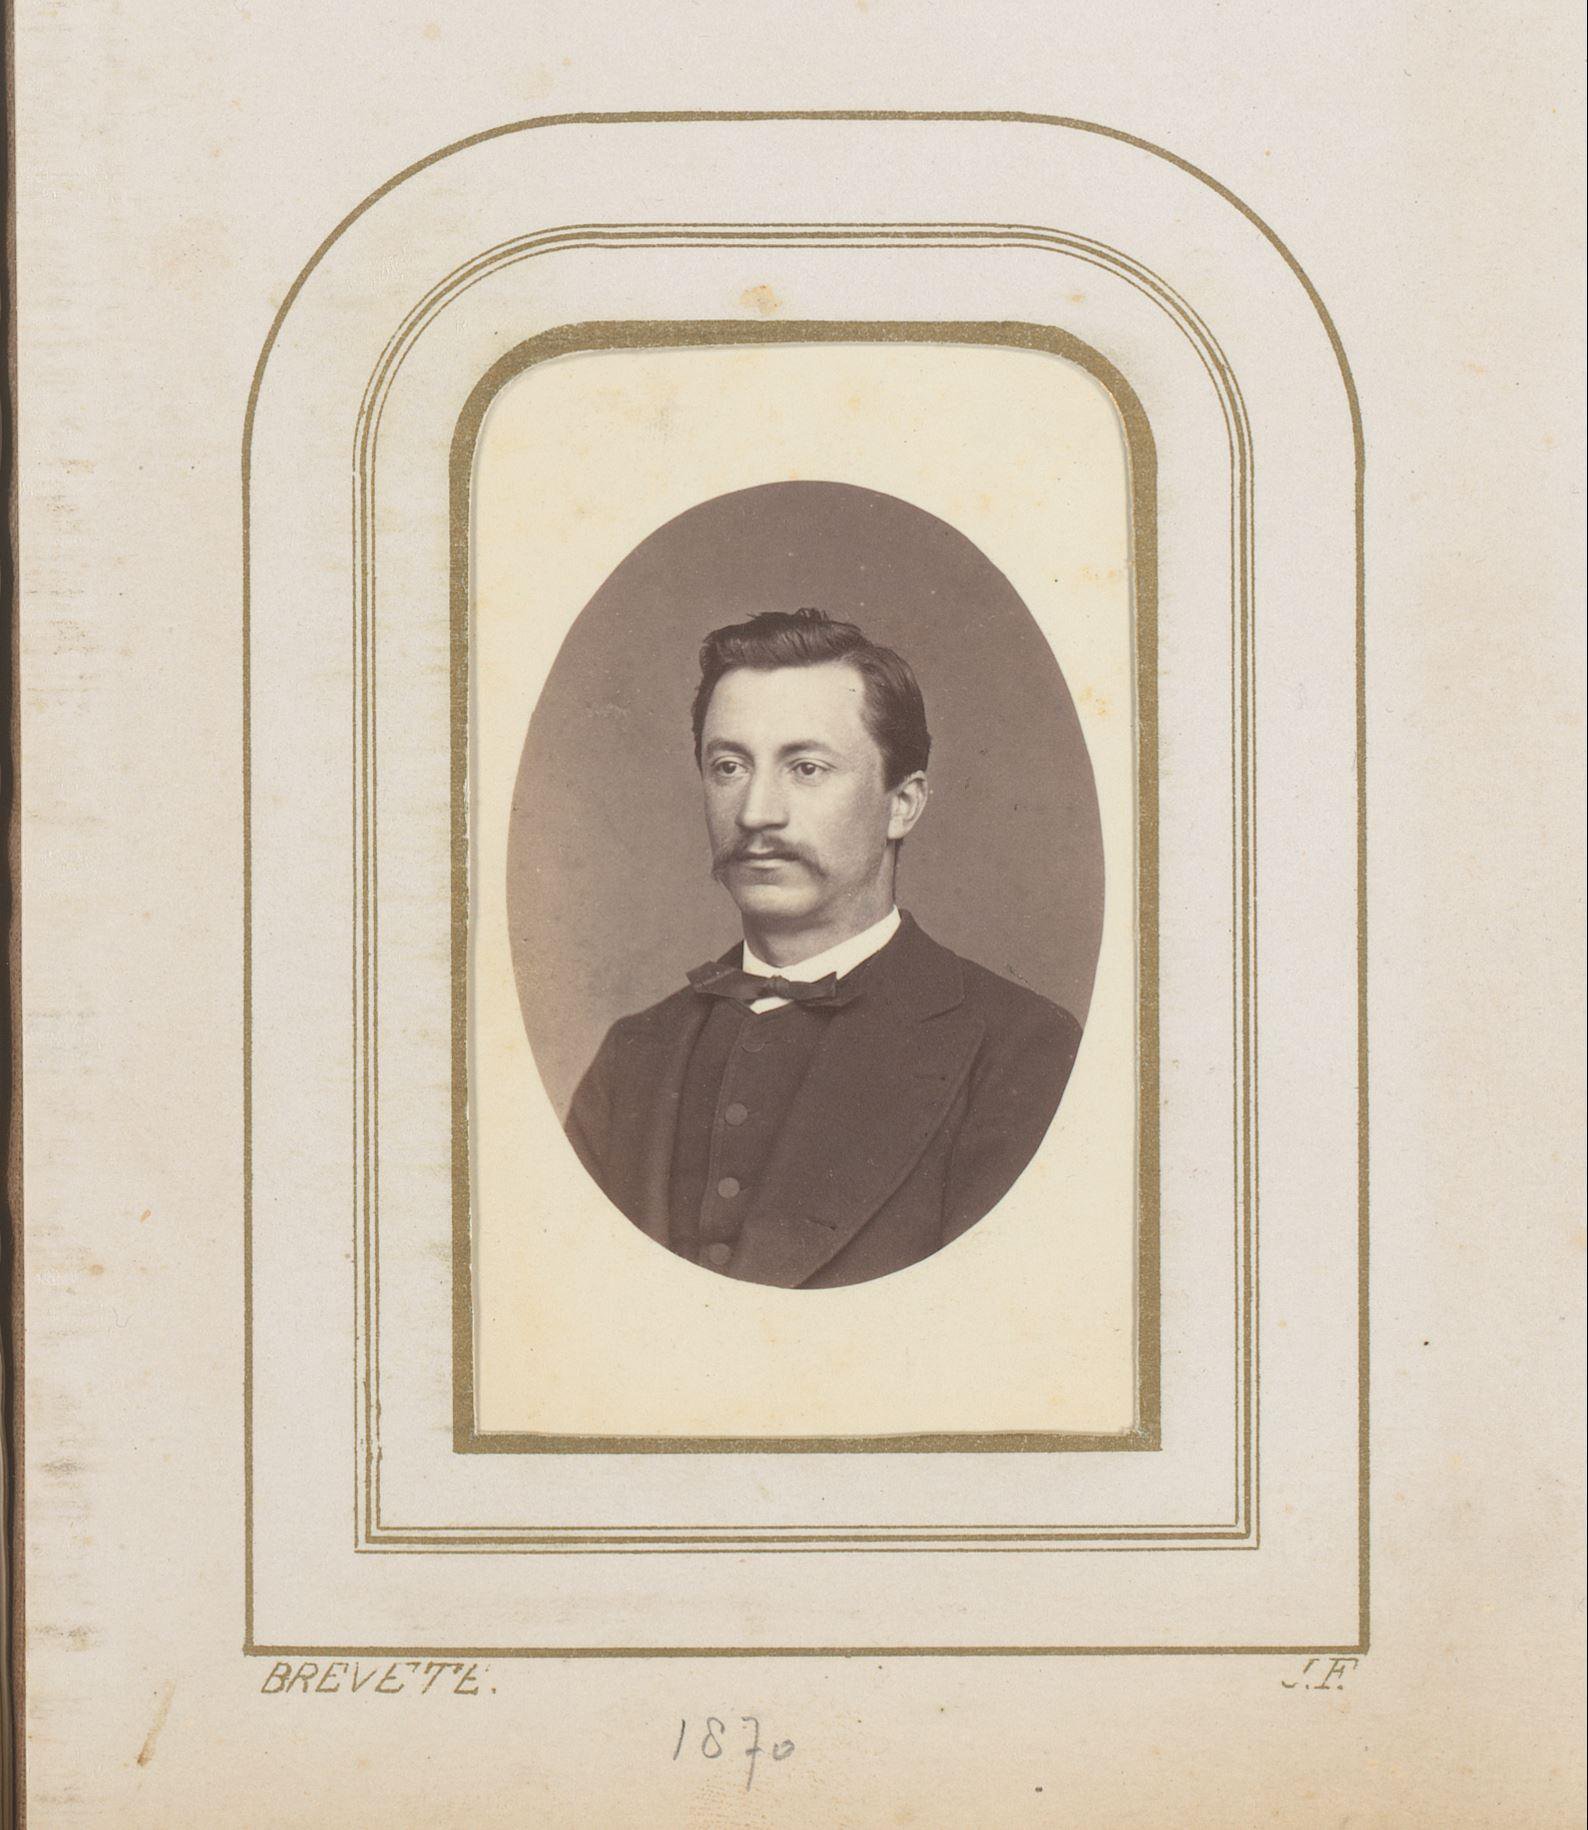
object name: carte de visite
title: Portret van een man met snor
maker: edmondo behles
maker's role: fotograaf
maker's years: 1841-1921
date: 1890-1895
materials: cardboard, photographic support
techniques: albumen print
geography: rome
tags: moustache, historical persons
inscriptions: date: ‘1870’, annotation: ‘Rome 21 avril 1870/ [...]’, inscription: ‘Edmond Behles/ Photographe/ Rome/ Atelier Mario dé fiori No. 28. au 1er’